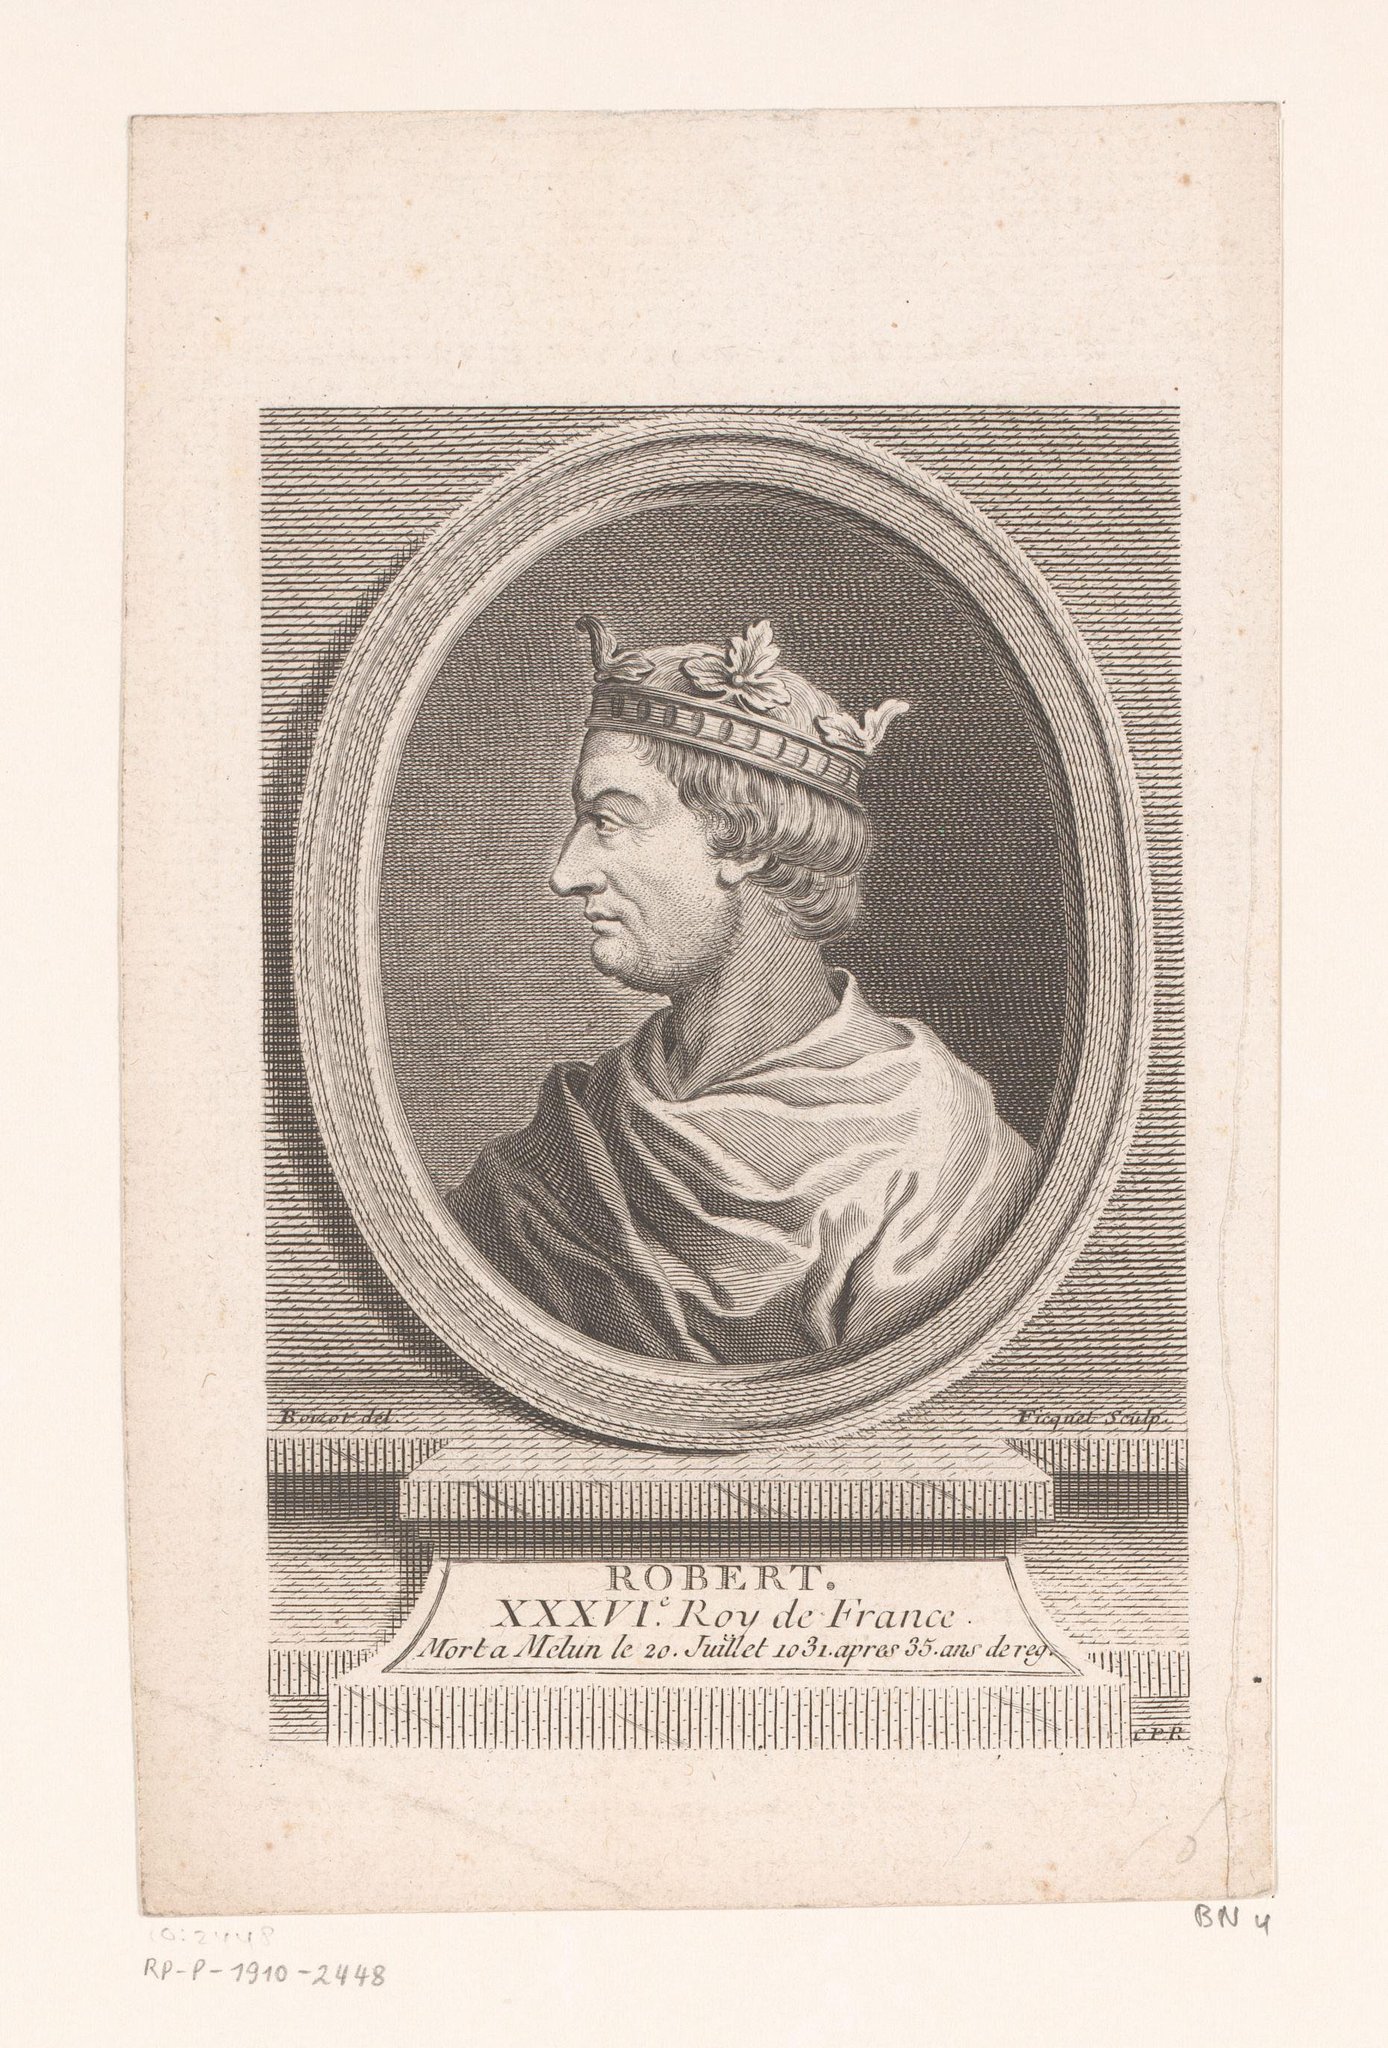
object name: print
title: Portret van Robert II van Frankrijk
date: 1741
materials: paper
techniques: engraving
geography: france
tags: ornament ~ medallion, historical persons, ruler, sovereign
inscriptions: collector's mark: Lugt 2228